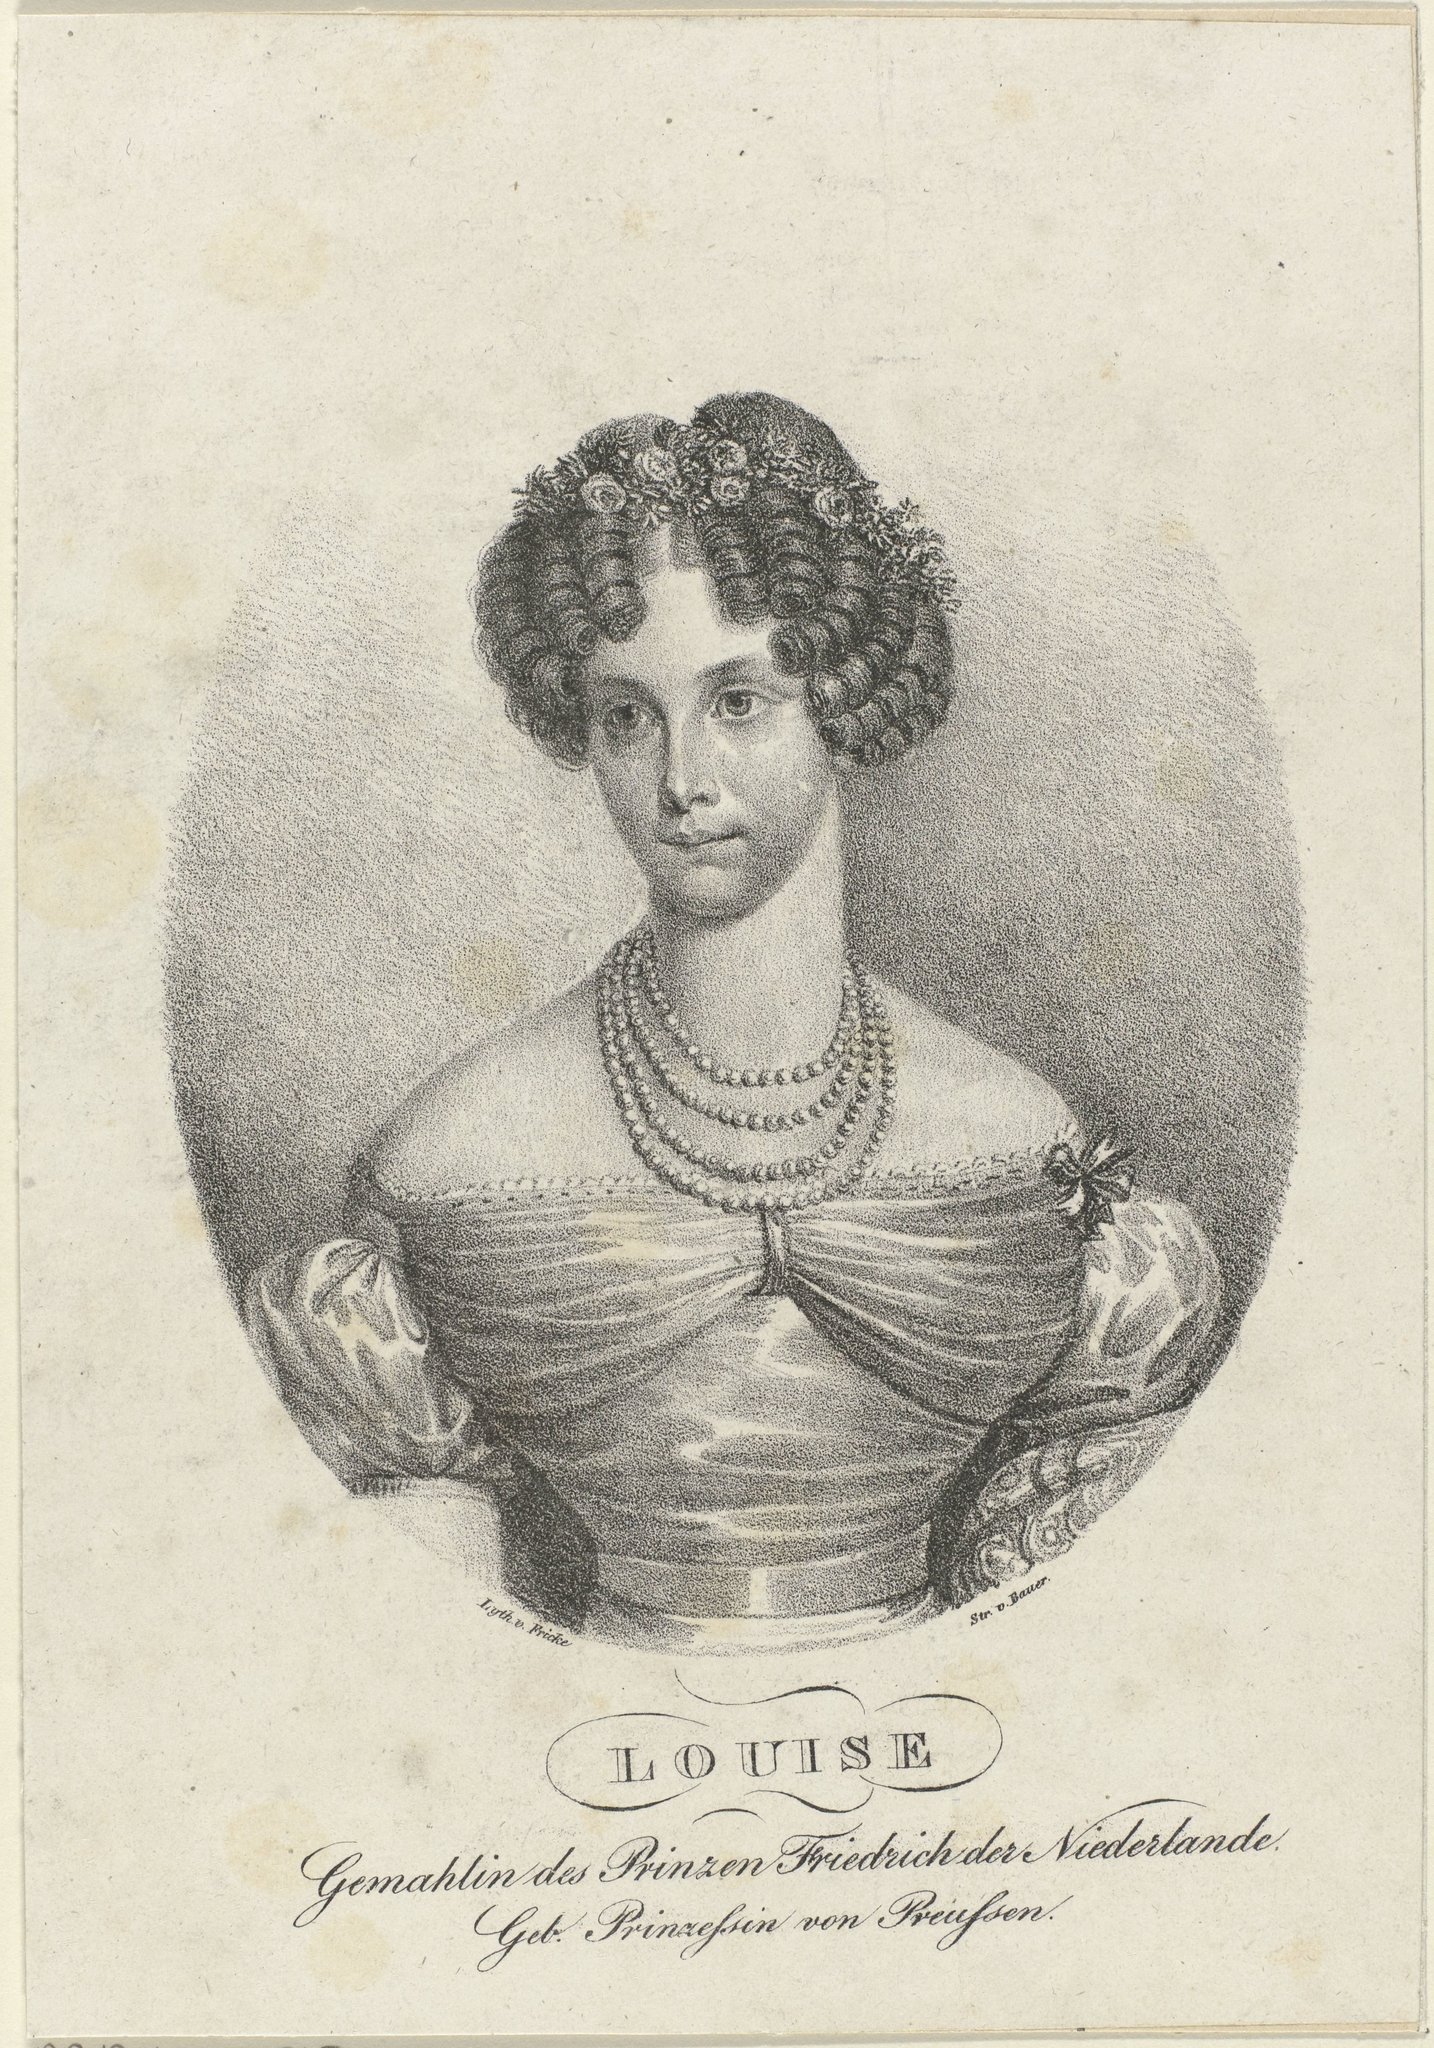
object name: print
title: Portret van Louise van Pruisen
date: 1825-1899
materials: paper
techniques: lithograph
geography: netherlands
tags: koningsbergen, wassenaar, prinses, louise van pruisen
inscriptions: collector's mark: Lugt 2228, collector's mark: Lugt 4269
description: Portret van Louise in een ovaal. In de ondermarge haar naam en titels.